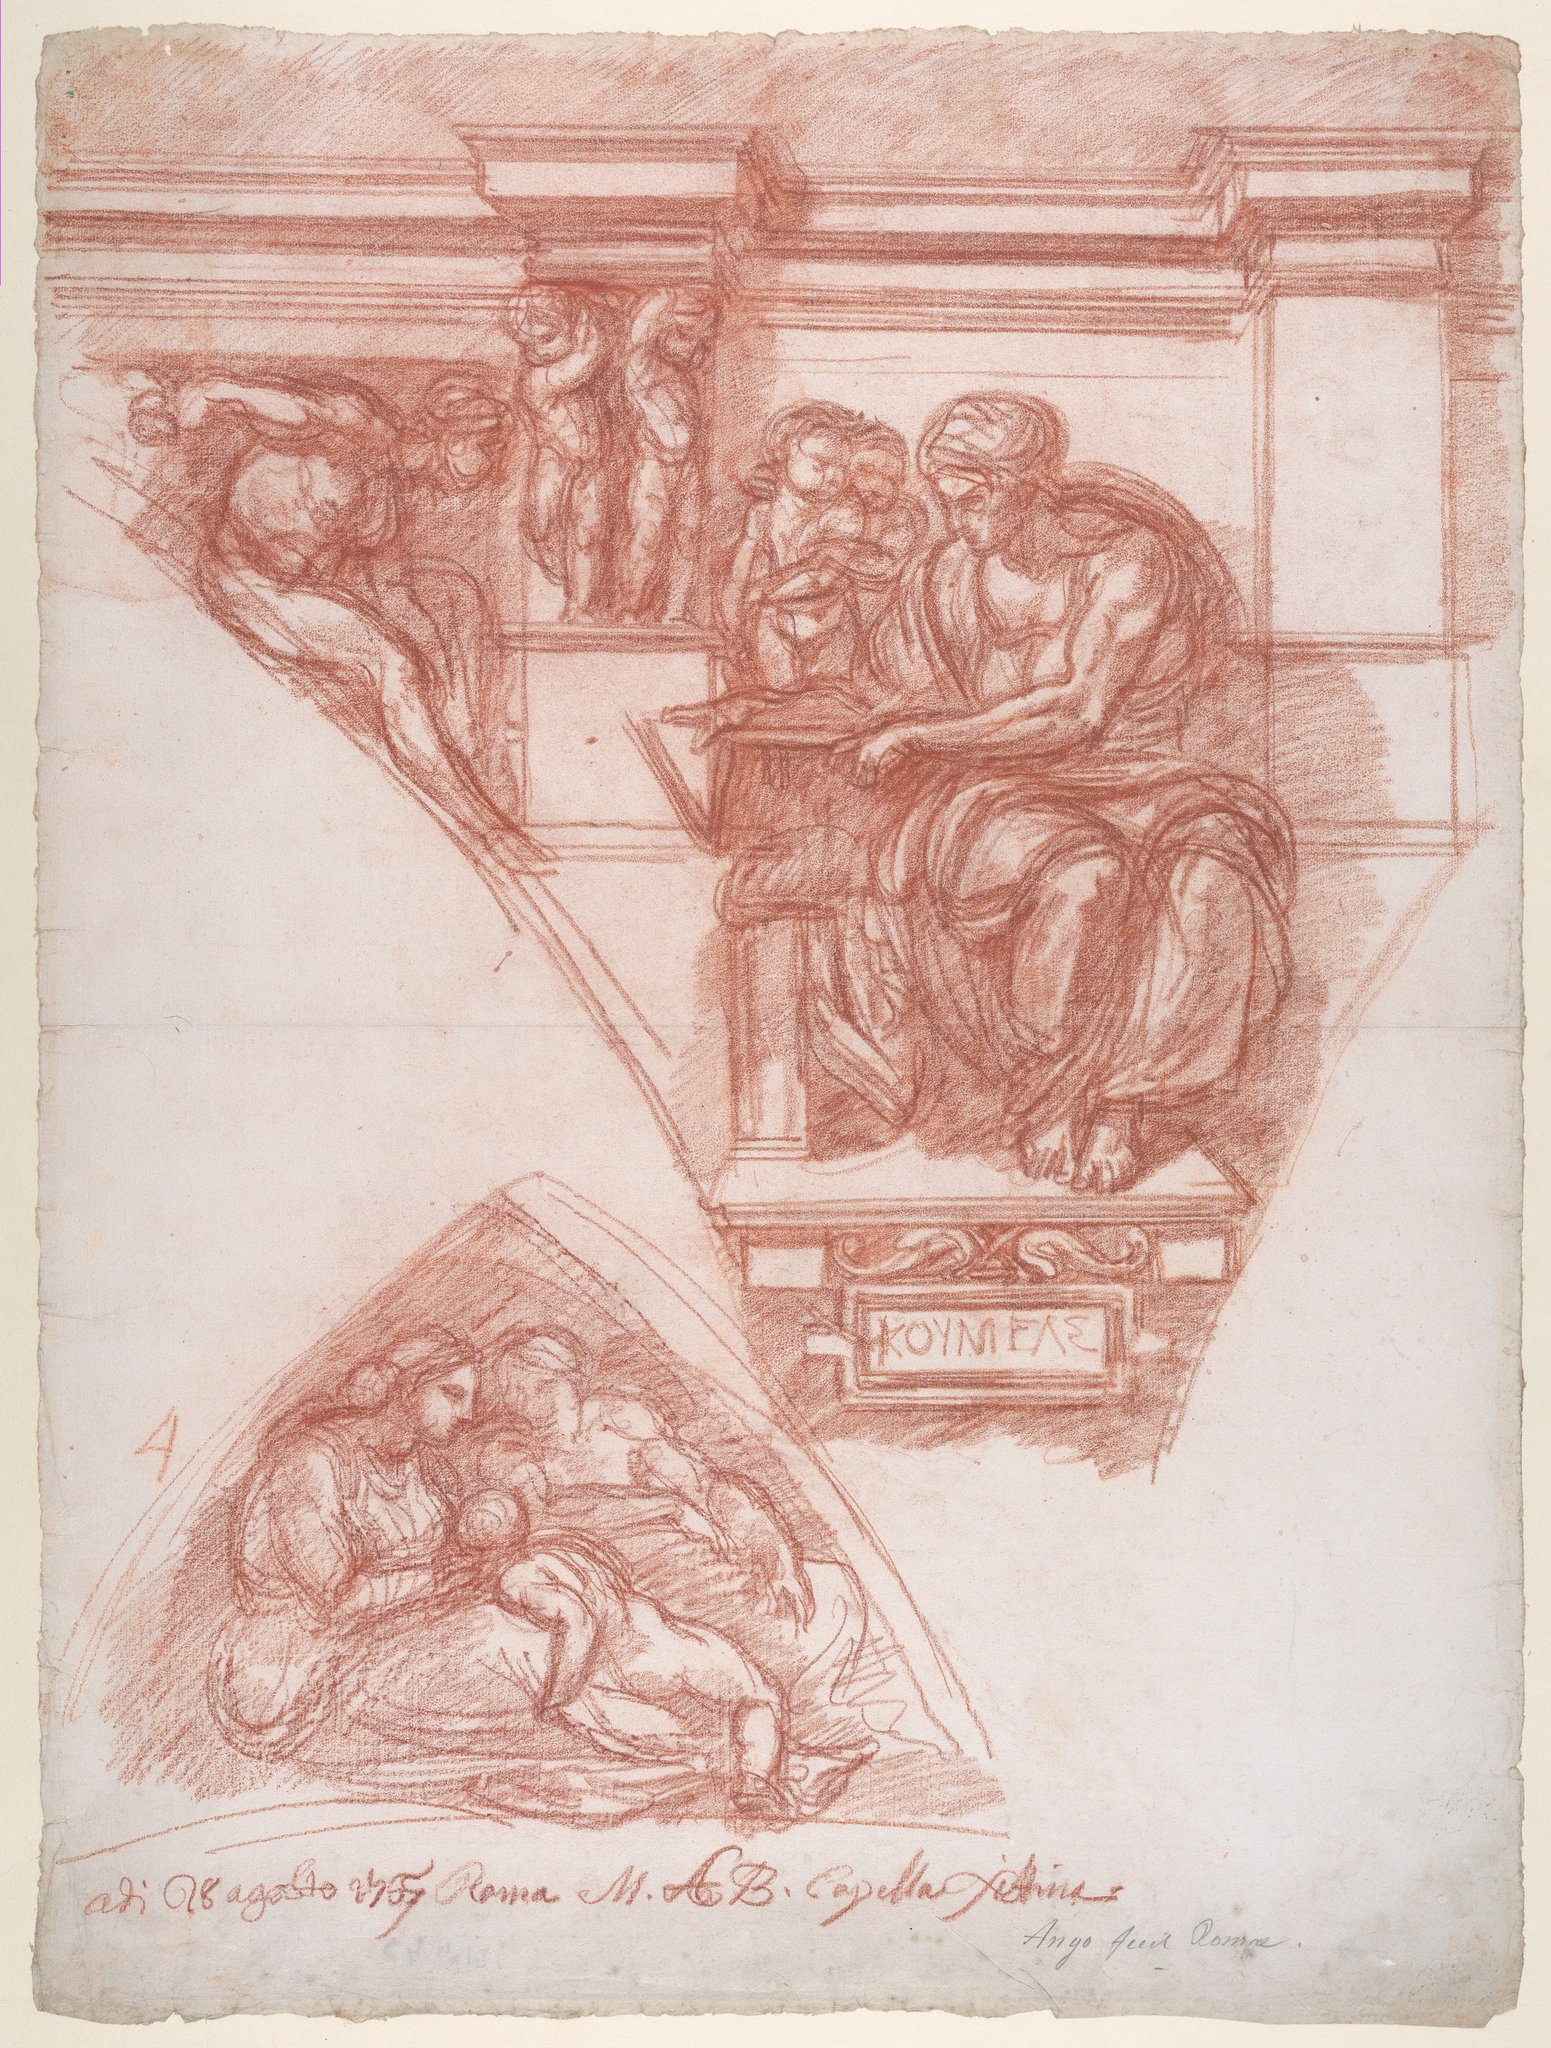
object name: drawing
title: The Cumaean Sibyl (after Michelangelo)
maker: jean robert ango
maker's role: artist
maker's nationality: french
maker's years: 1759-1773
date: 1767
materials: chalk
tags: children,women,sibyl